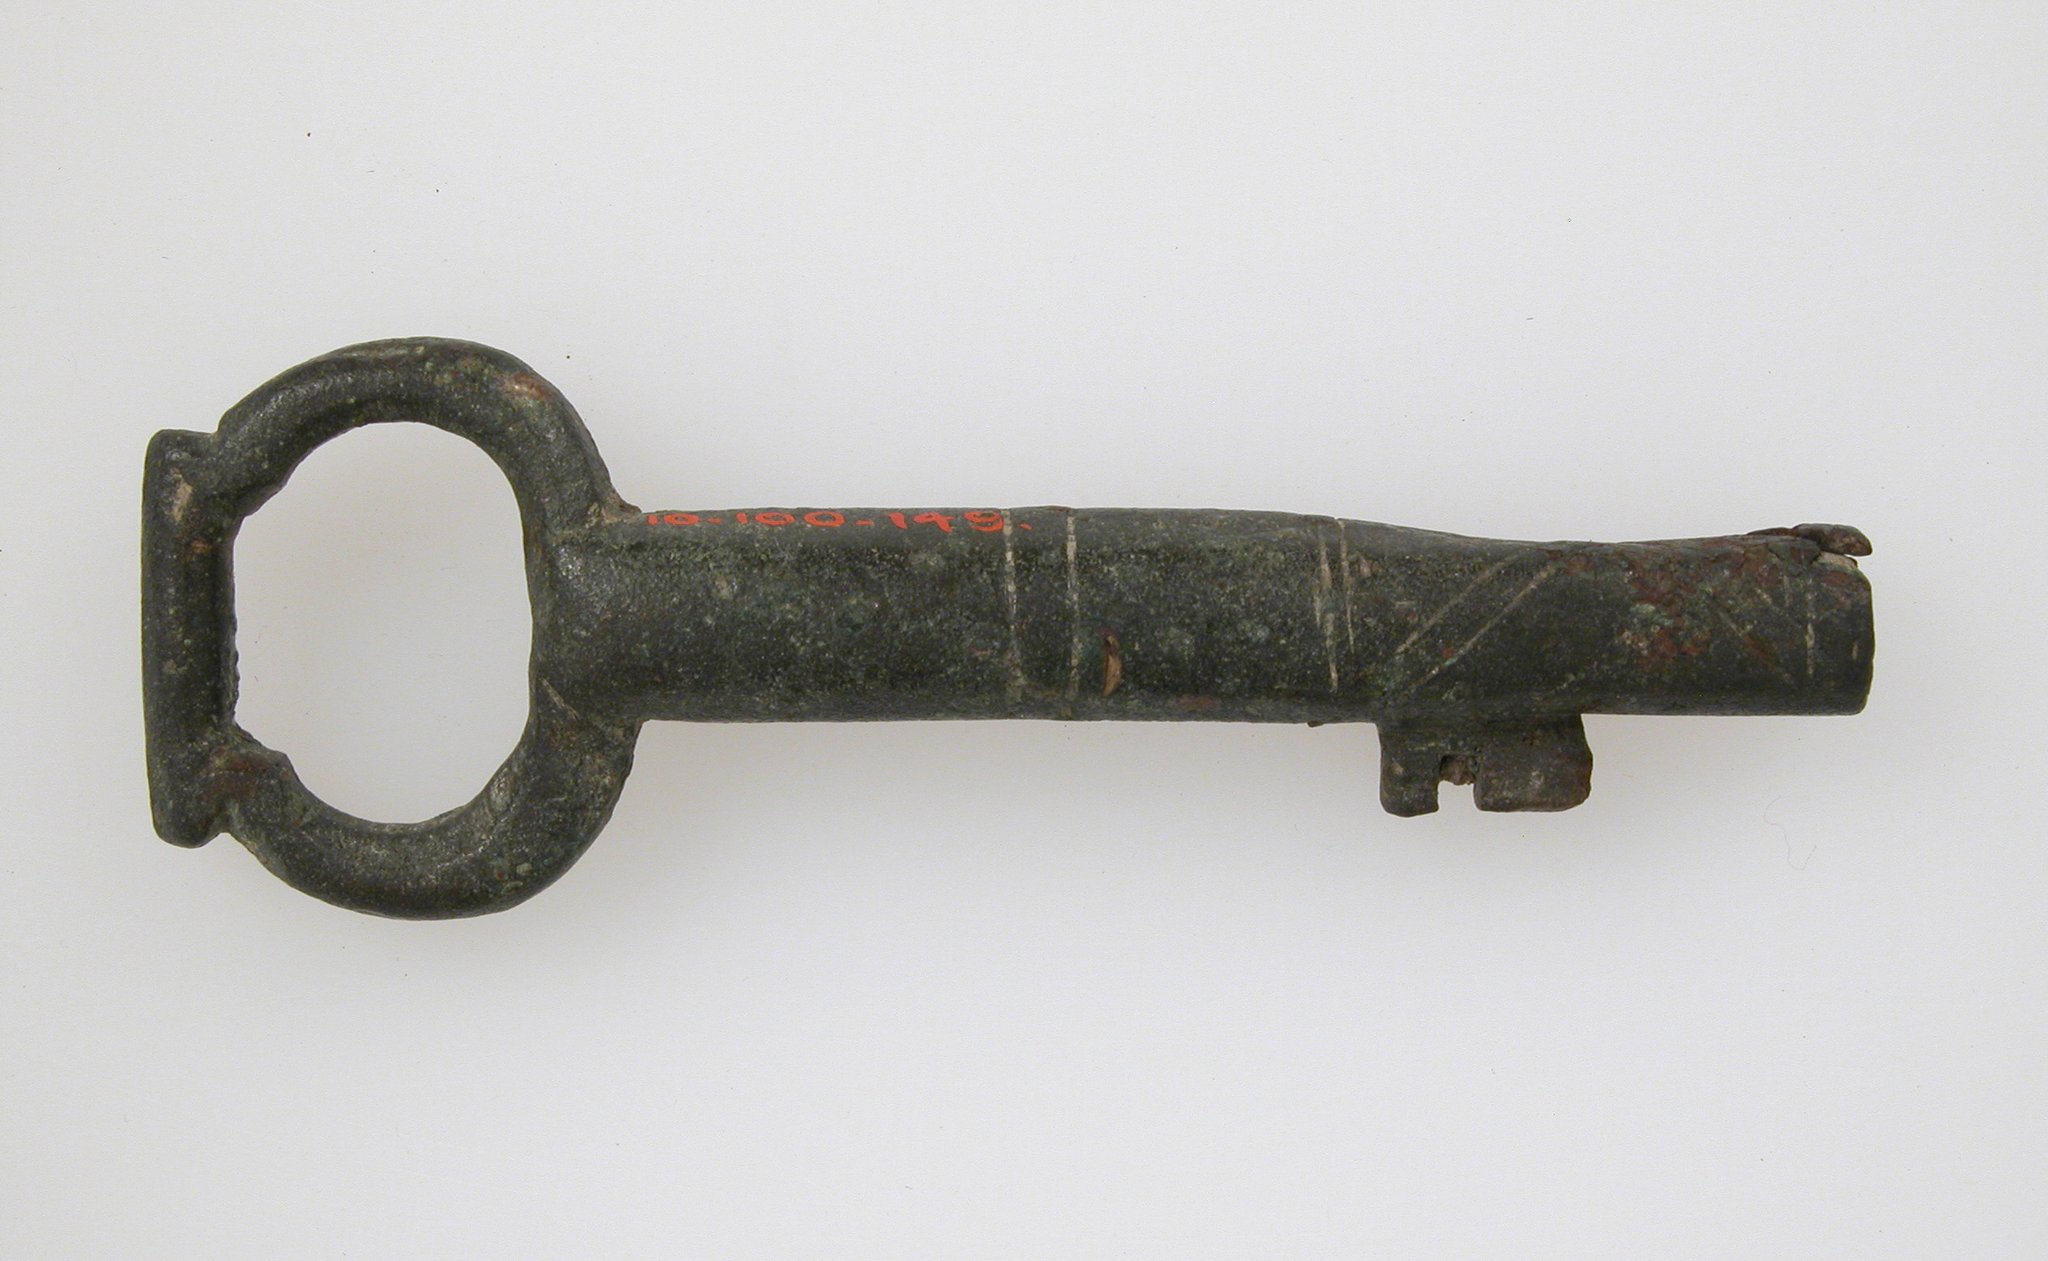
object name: key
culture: german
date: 1301-1400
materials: copper alloy